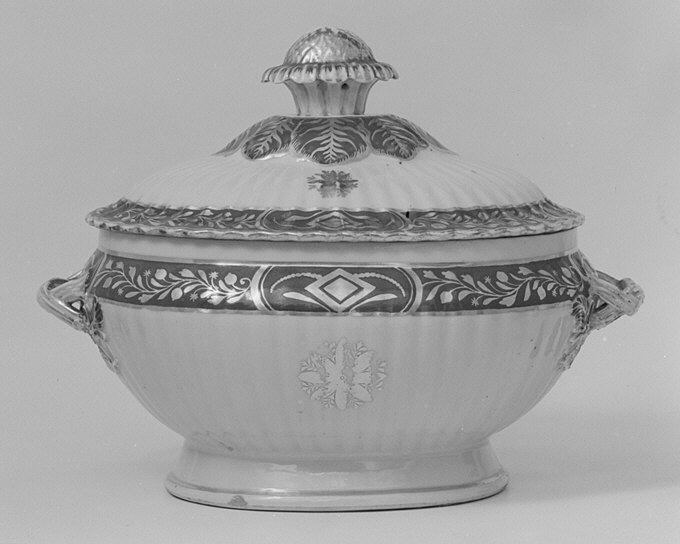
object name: tureen with cover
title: Tureen with cover (part of a service)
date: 1785-1800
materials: hard paste porcelain